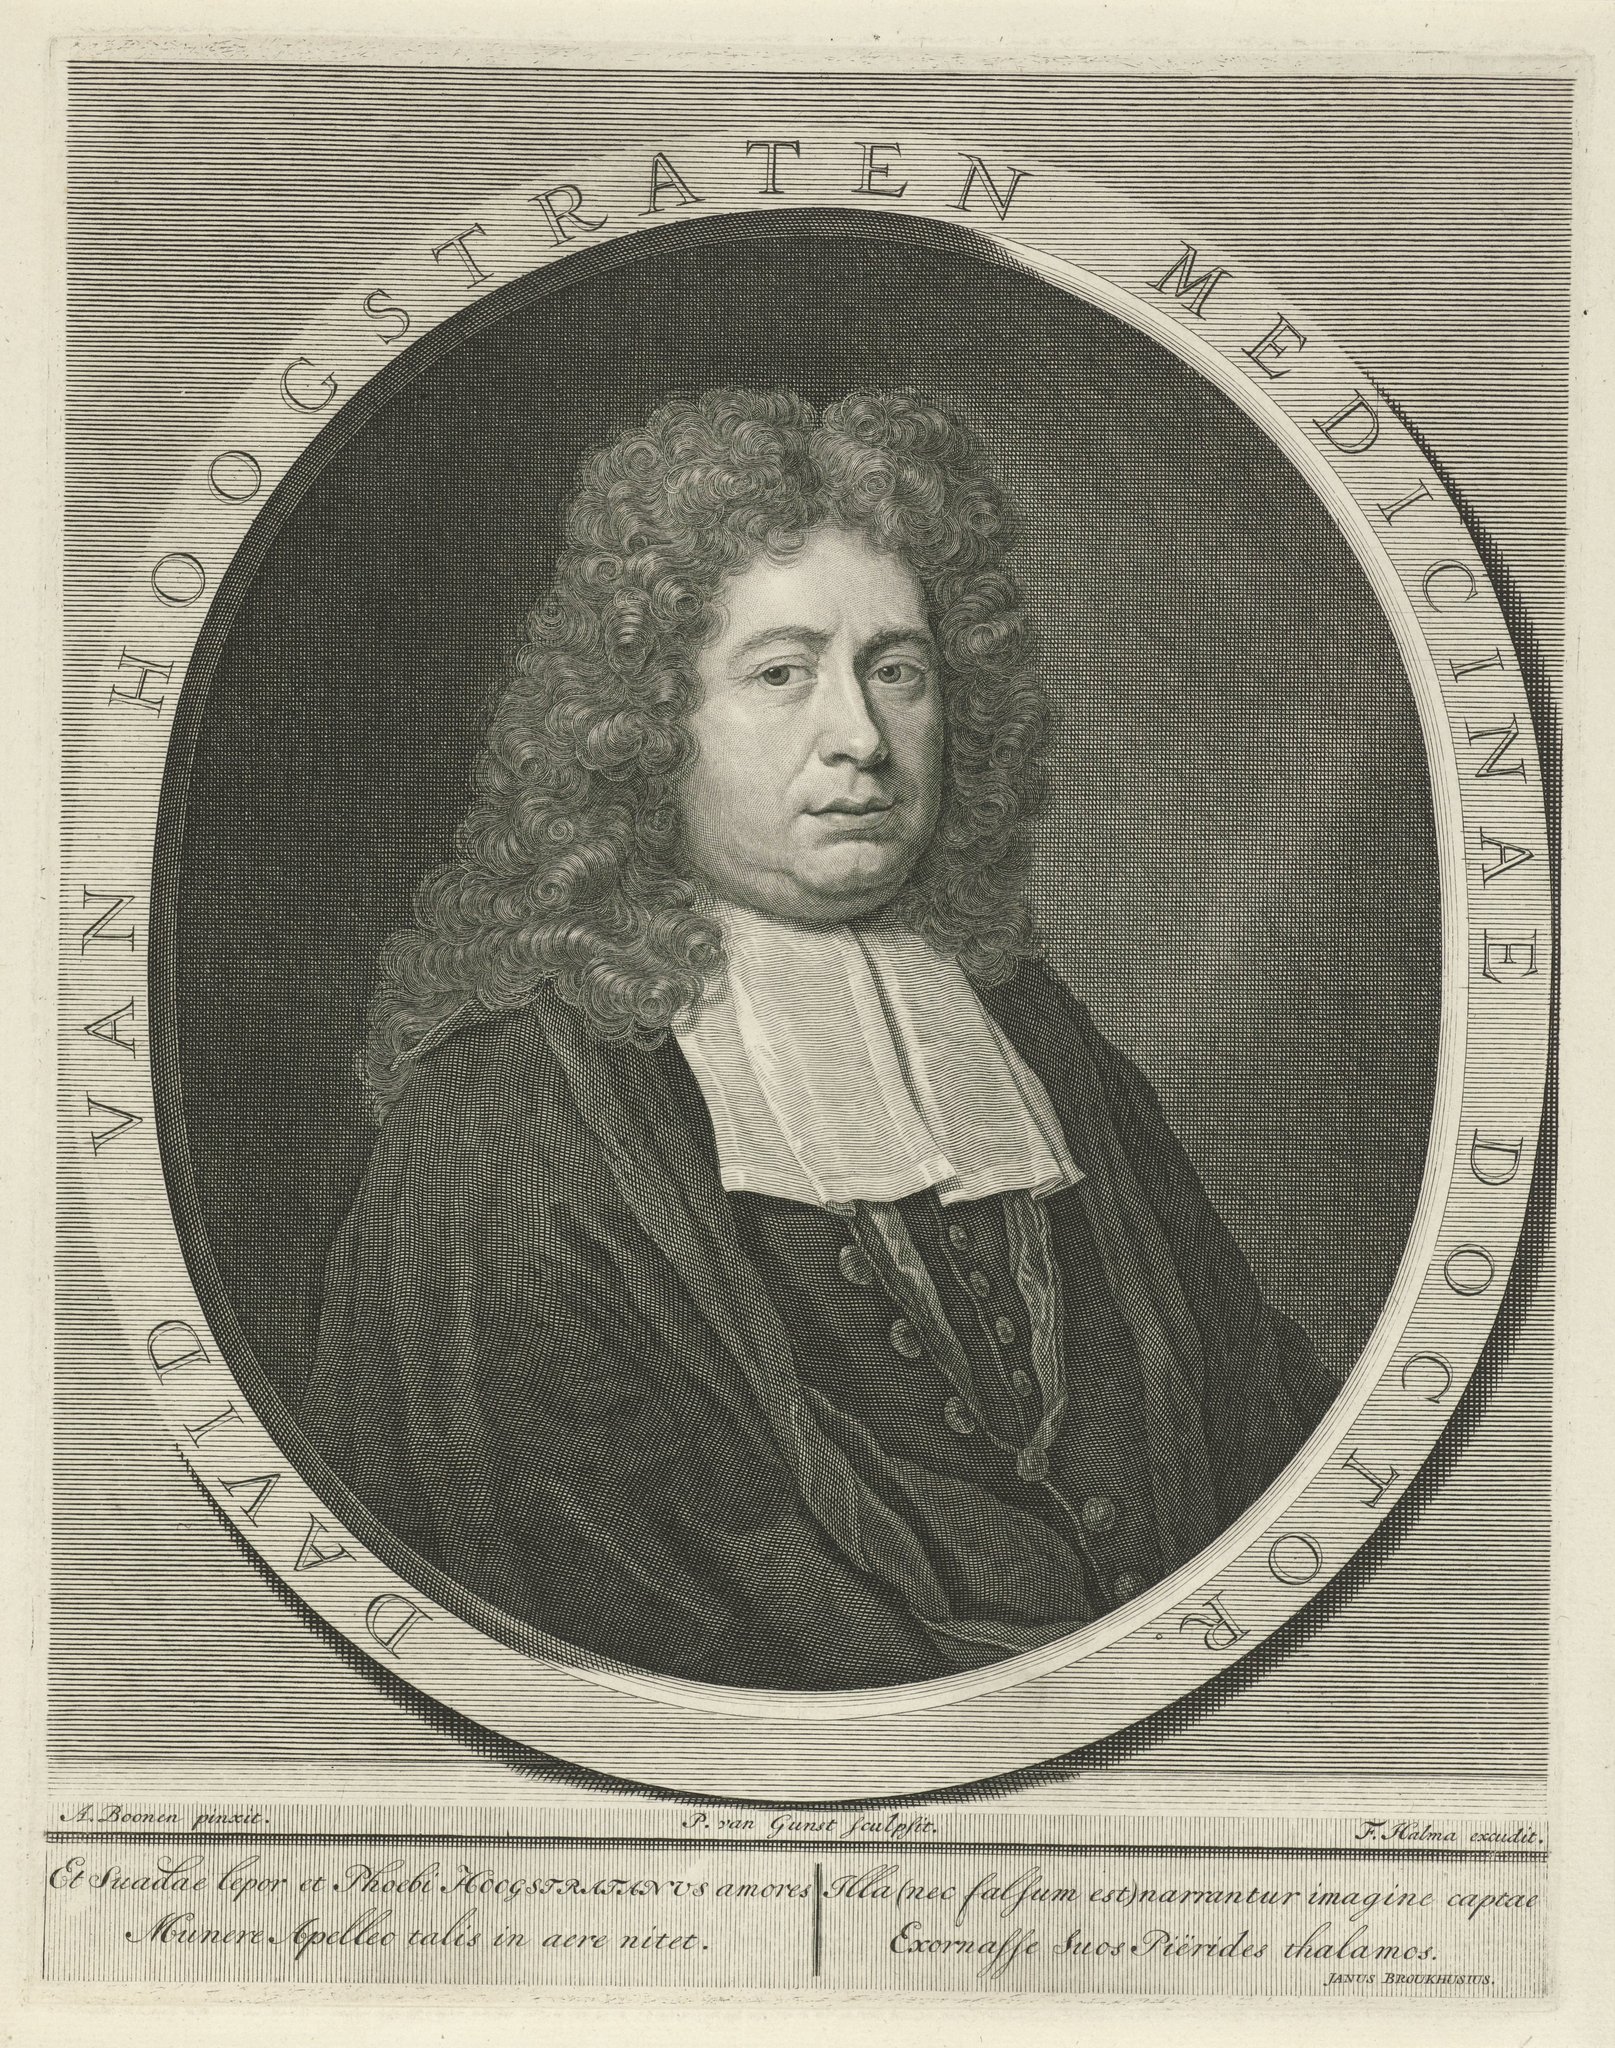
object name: print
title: Portret van David Fransz. van Hoogstraten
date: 1679-1722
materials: paper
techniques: engraving, etching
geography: amsterdam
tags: rotterdam, amsterdam, david fransz. van hoogstraten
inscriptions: collector's mark: Lugt 2228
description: David Fransz. van Hoogstraten, arts in Dordrecht maar vooral bekend om zijn schrijf- en dichtwerk. Onder de prent een Latijns onderschrift over zijn leven.